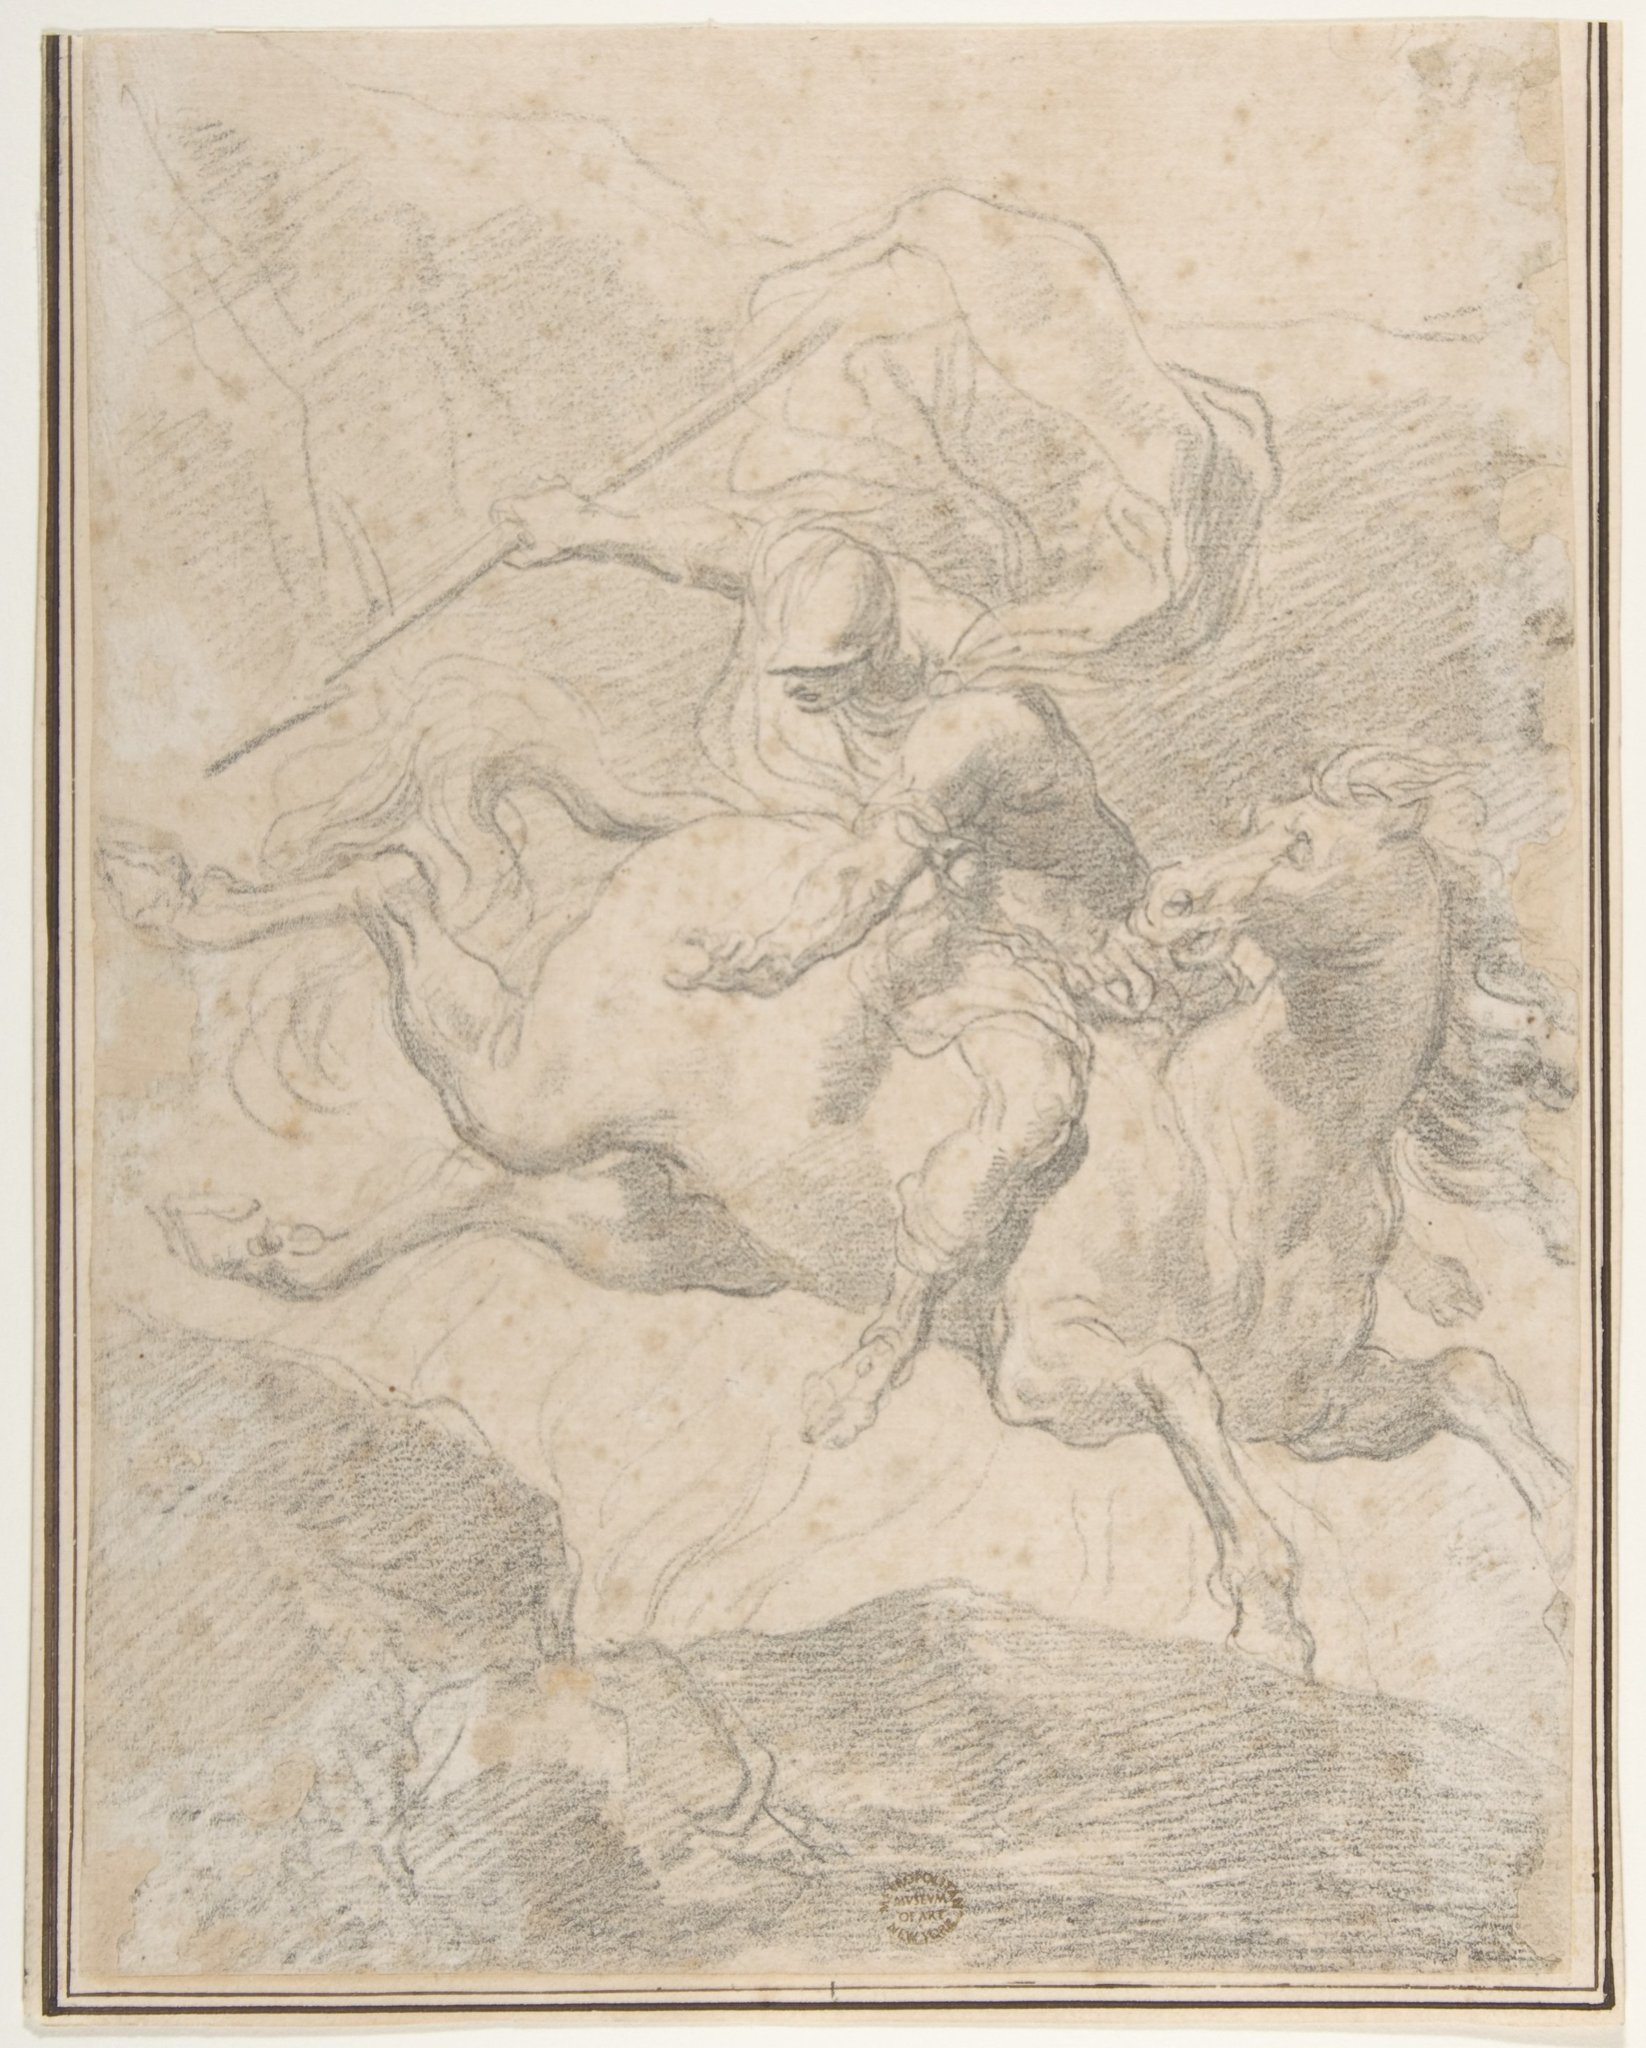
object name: drawing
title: Marcus Curtius Leaping into the Chasm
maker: gaetano gandolfi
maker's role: artist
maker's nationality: italian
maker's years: 1734-1802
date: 1734-1802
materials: chalk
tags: men,horses